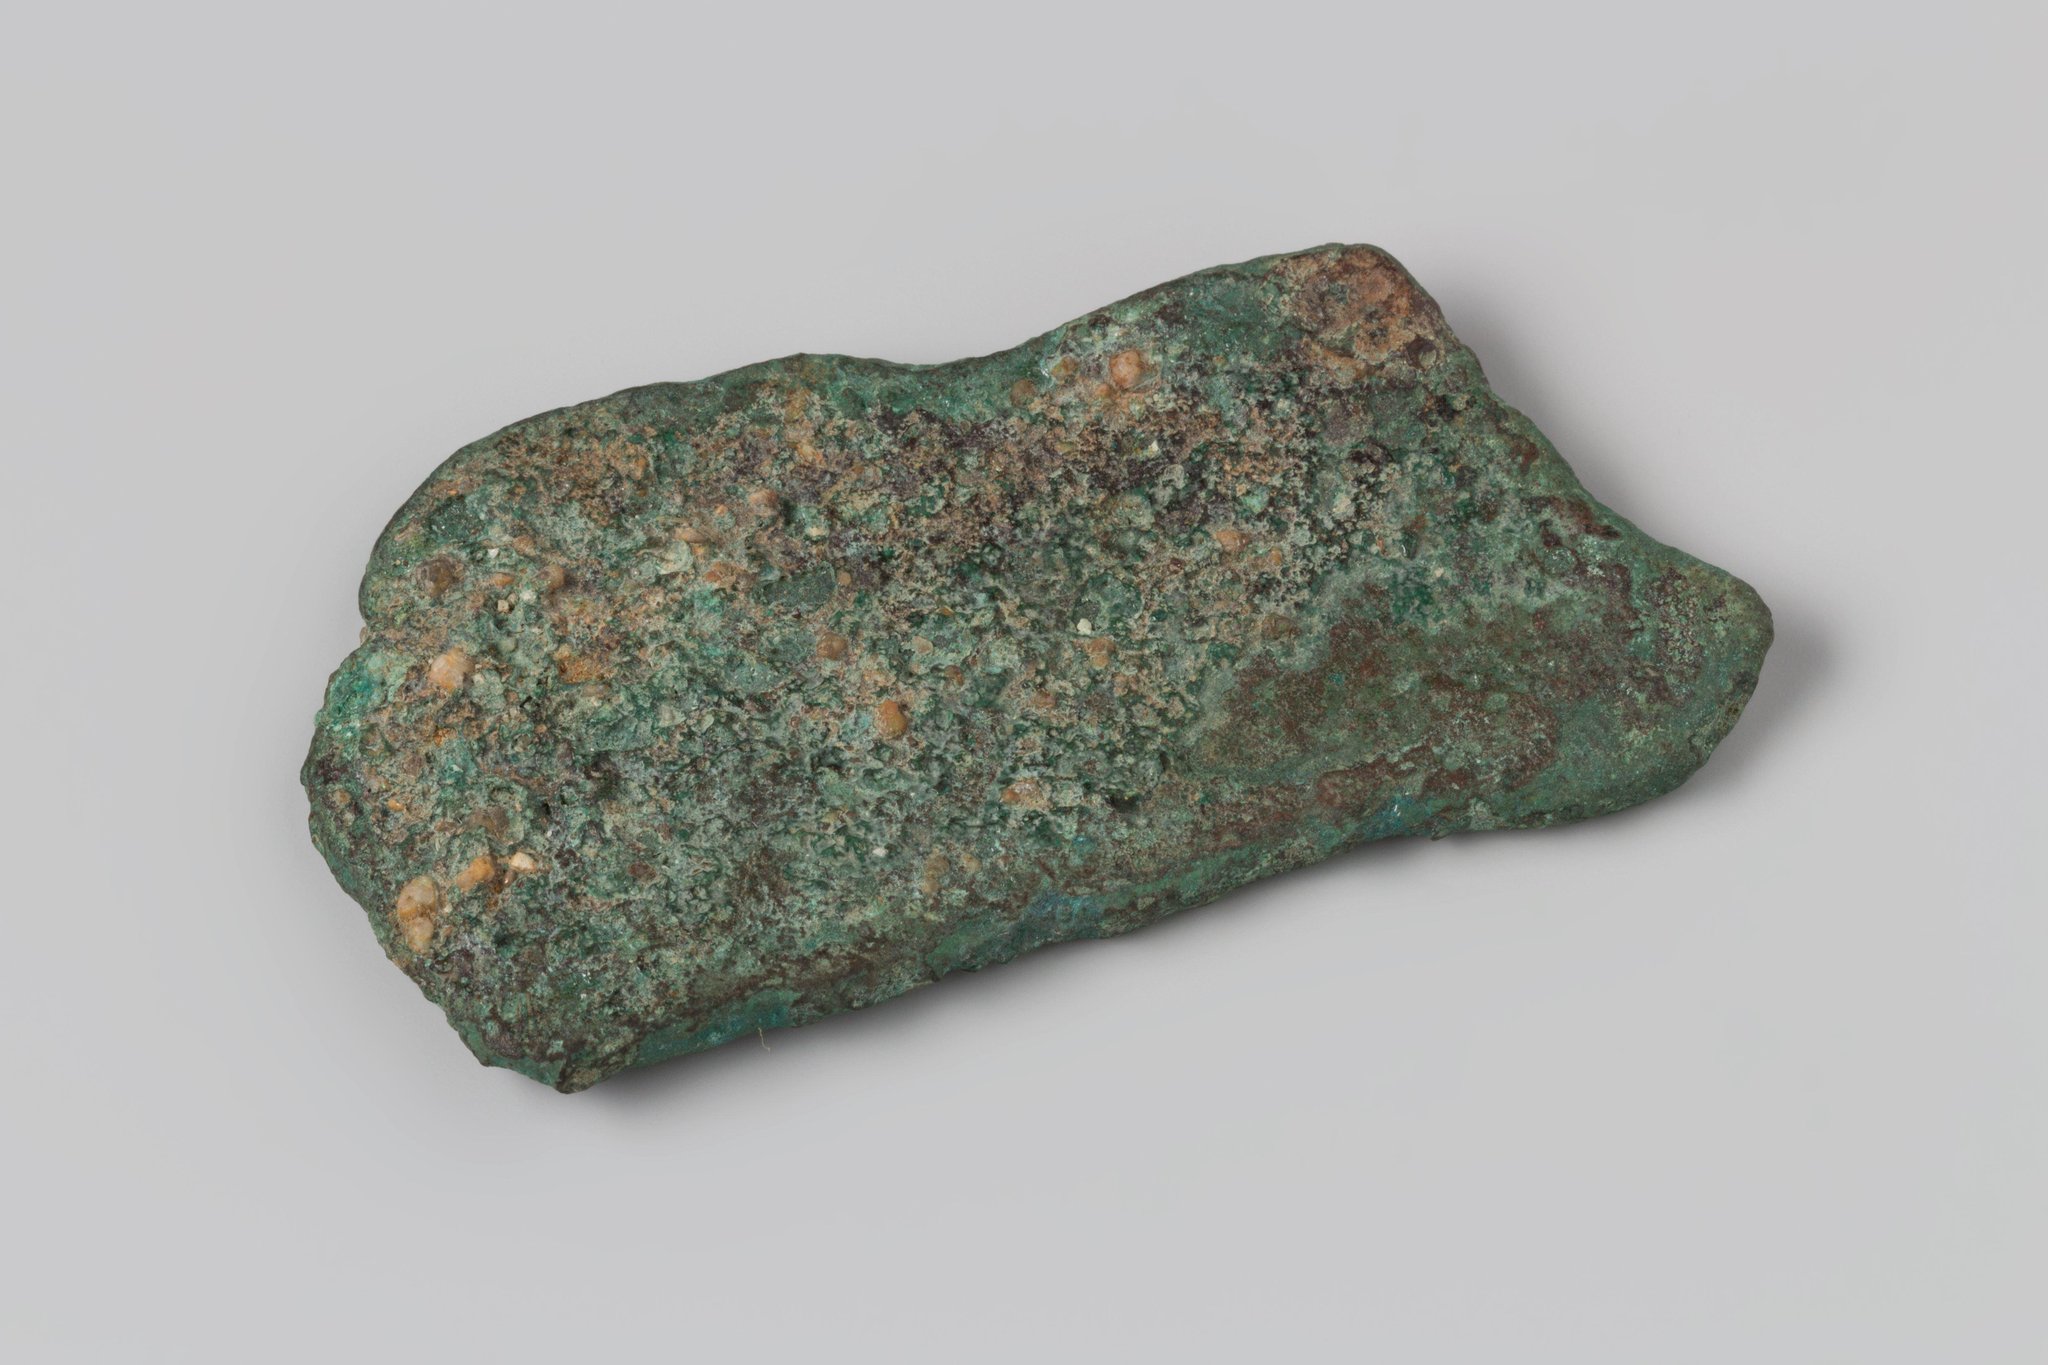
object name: scheepswrakvondst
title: Fragment van koper uit het wrak van de Oost-Indiëvaarder Hollandia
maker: Anonymous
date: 1700-1743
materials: copper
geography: netherlands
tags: verenigde oostindische compagnie, hollandia (schip), annet